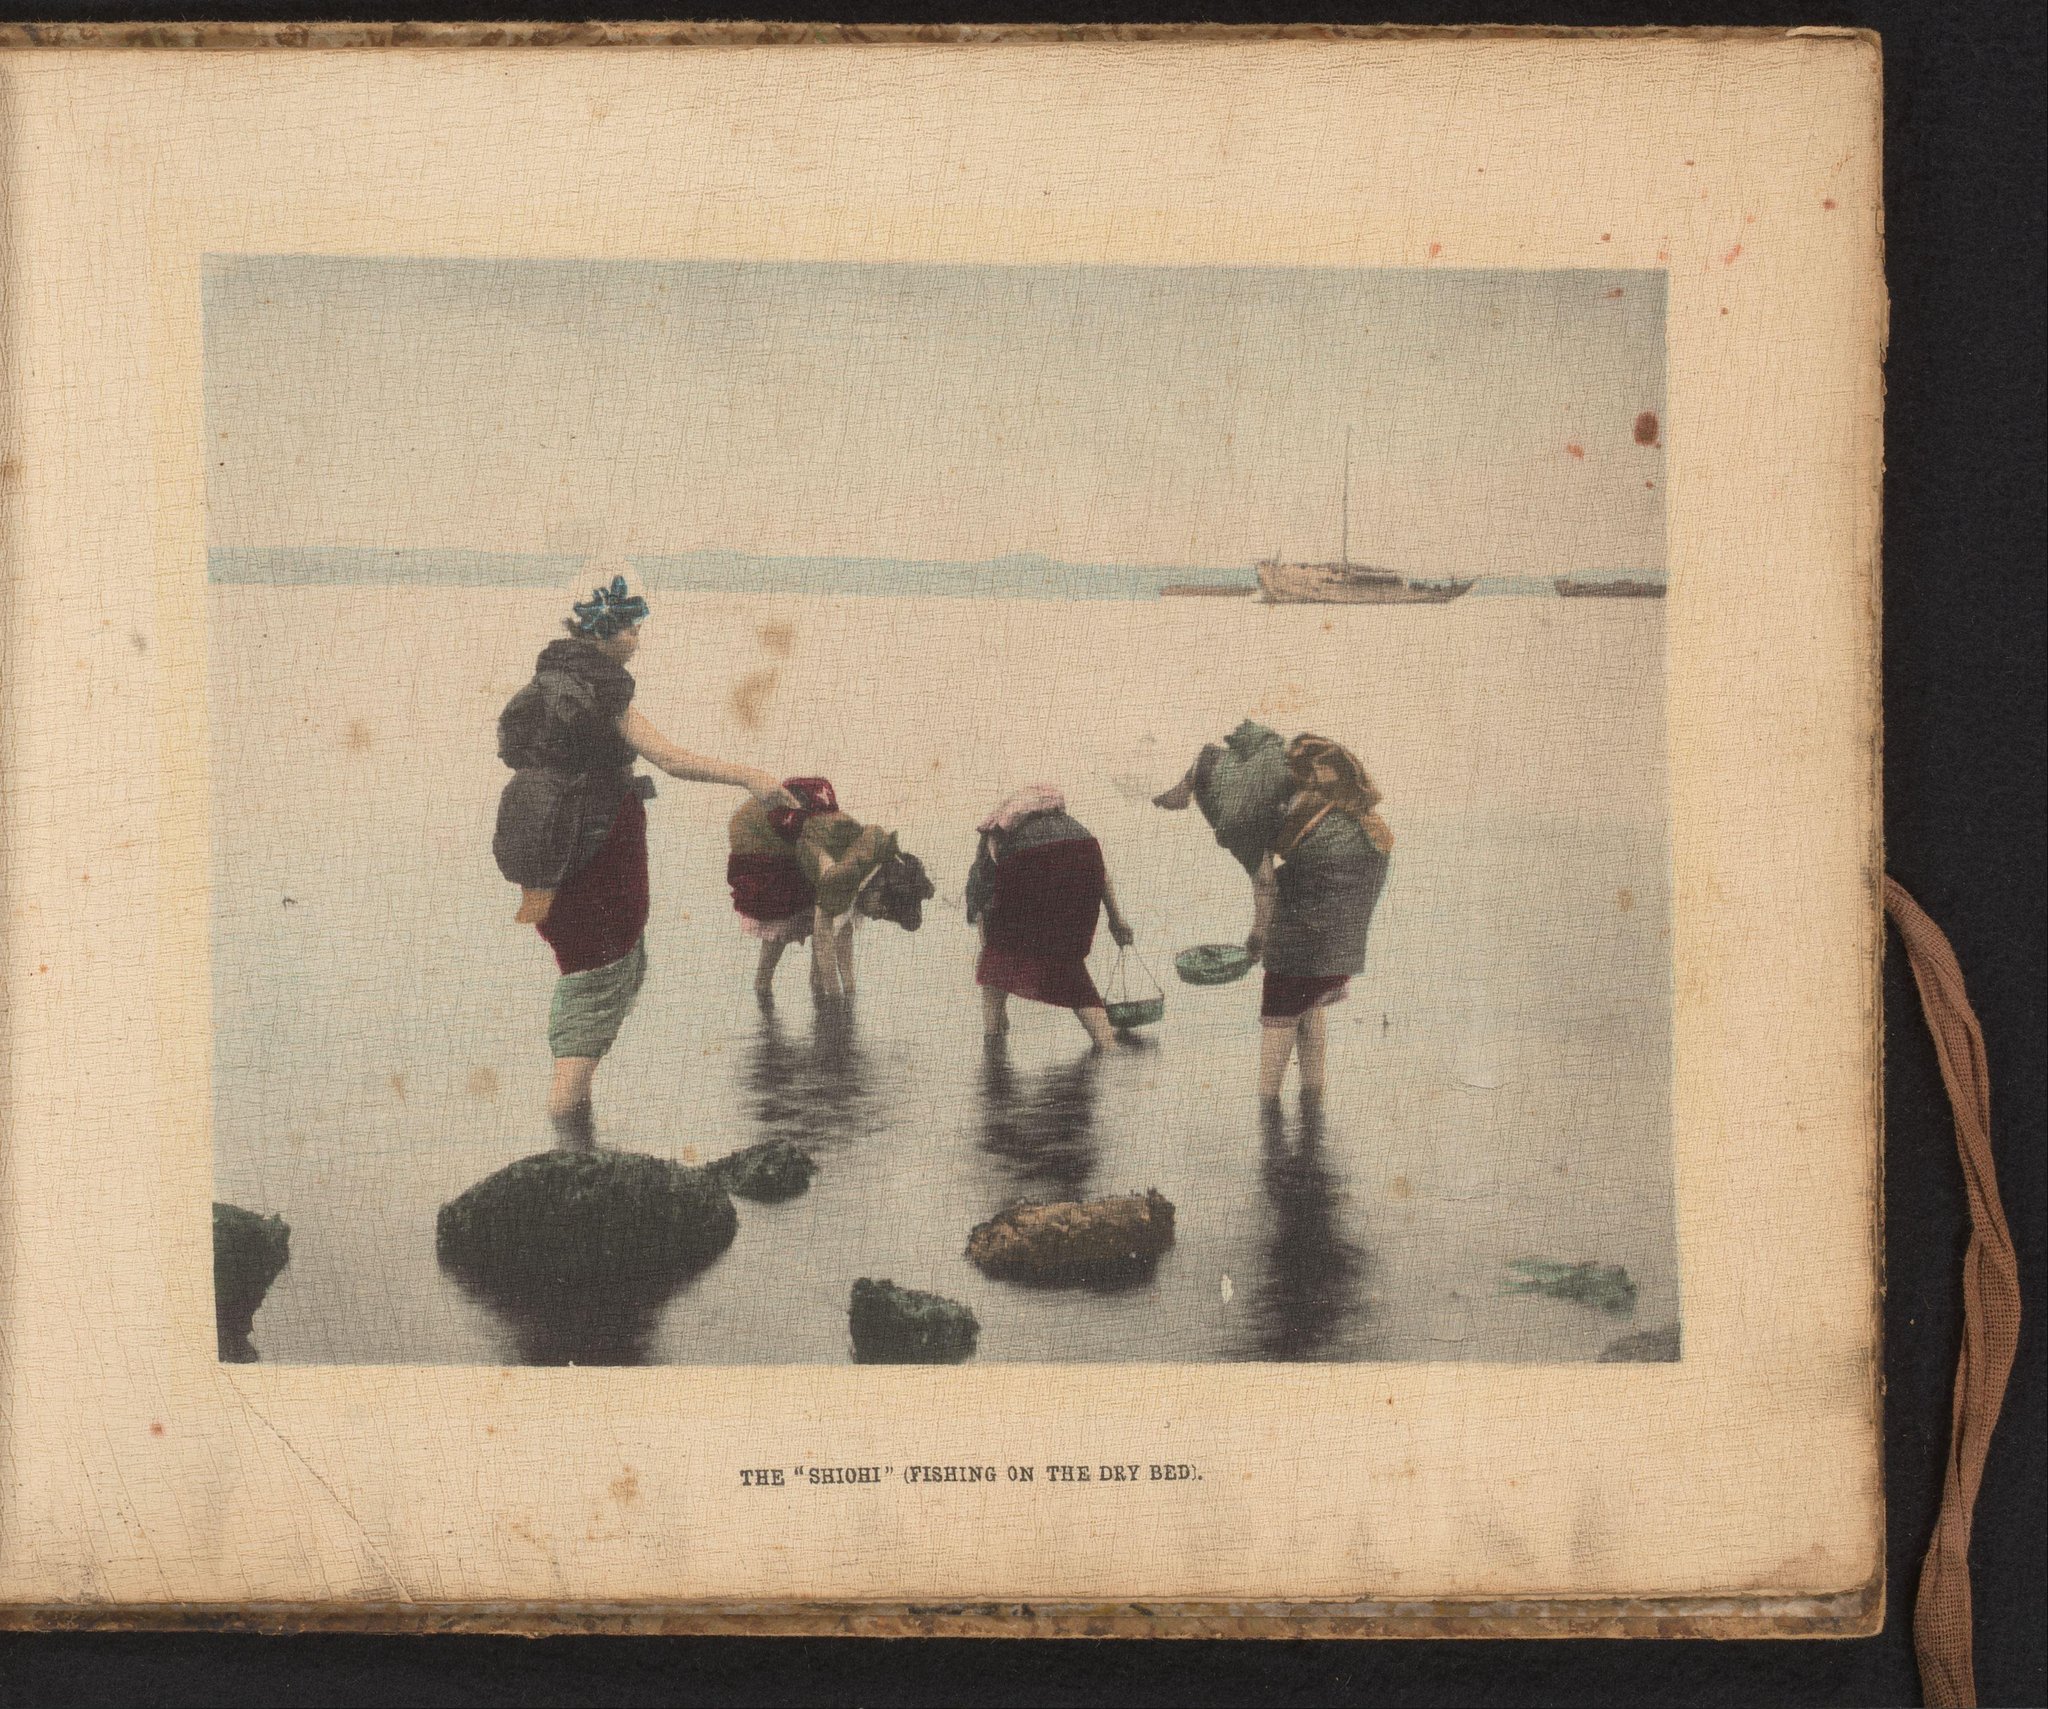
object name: photomechanical print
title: Drie onbekende vrouwen op zoek naar vis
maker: Anonymous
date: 1891-1896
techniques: collotype process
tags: adult woman, sea and coastal fishery, japan